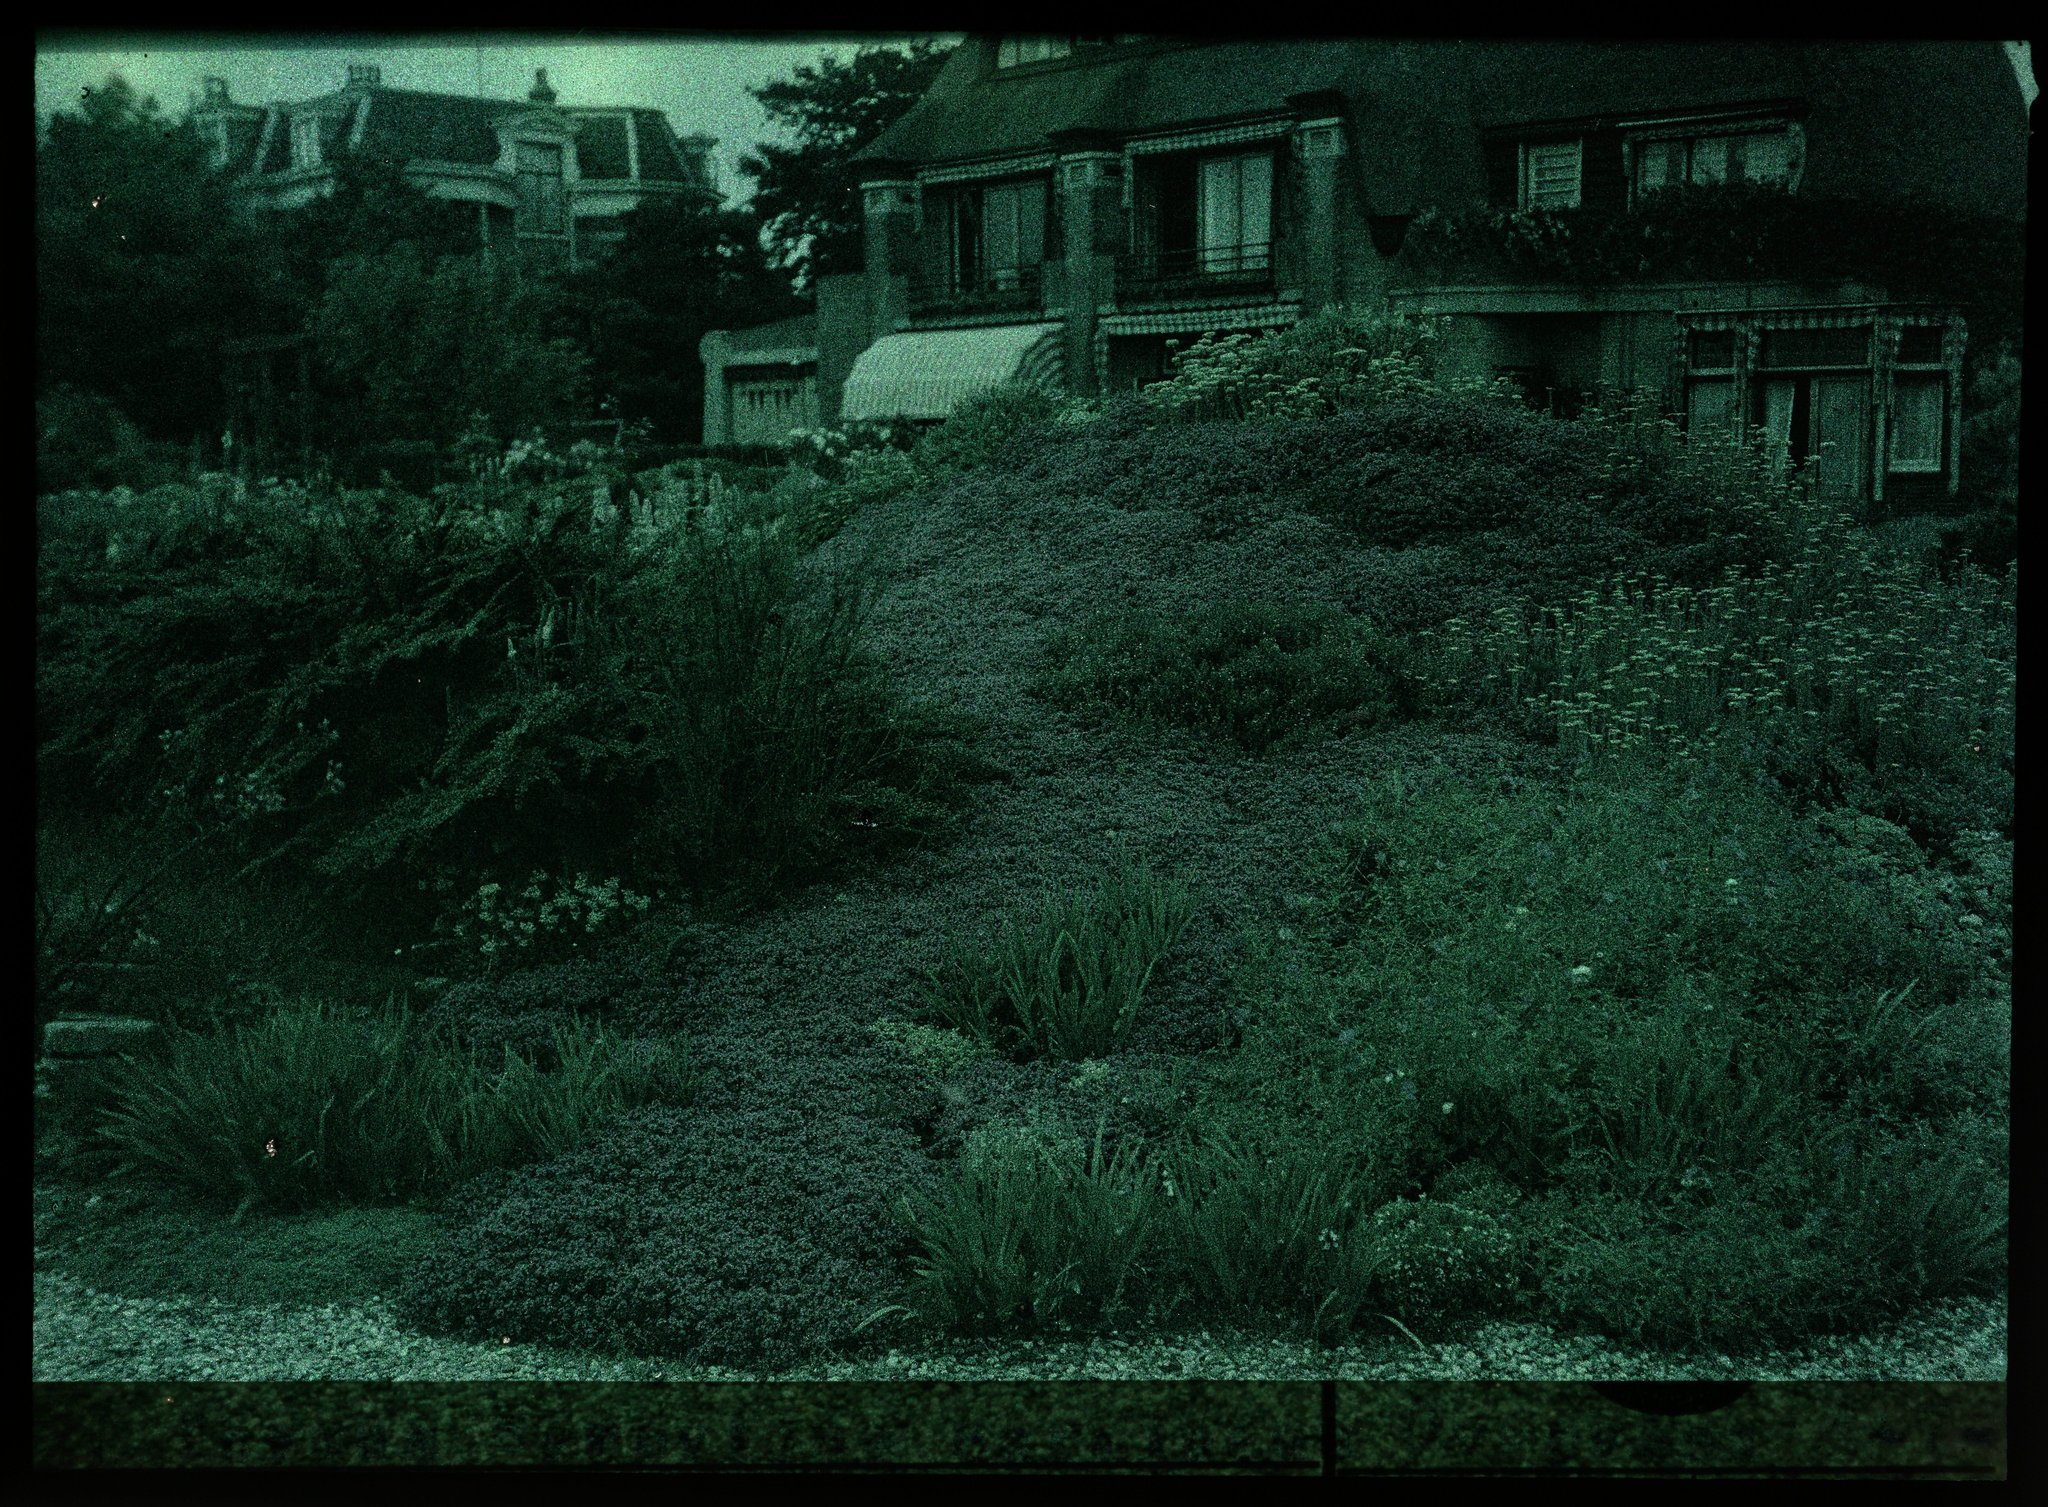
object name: color slide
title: Groene planten, met huizen op de achtergrond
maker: adolphe burdet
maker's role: fotograaf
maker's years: 1860-1940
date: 1907-1930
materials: glass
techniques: autochrome process, slide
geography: netherlands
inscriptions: annotation: ‘[...] Thymus Serpyllum carmineus Overveen 4-7-’